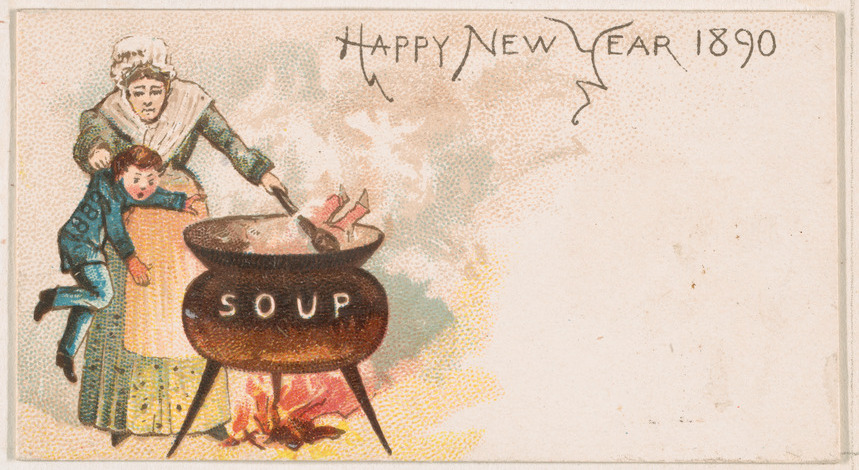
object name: print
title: Happy New Year 1890, from the New Years 1890 series (N227) issued by Kinney Bros.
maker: kinney brothers tobacco company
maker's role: publisher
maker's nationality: american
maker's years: 1869-2011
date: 1889-1890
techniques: color lithograph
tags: boys,women,cooking